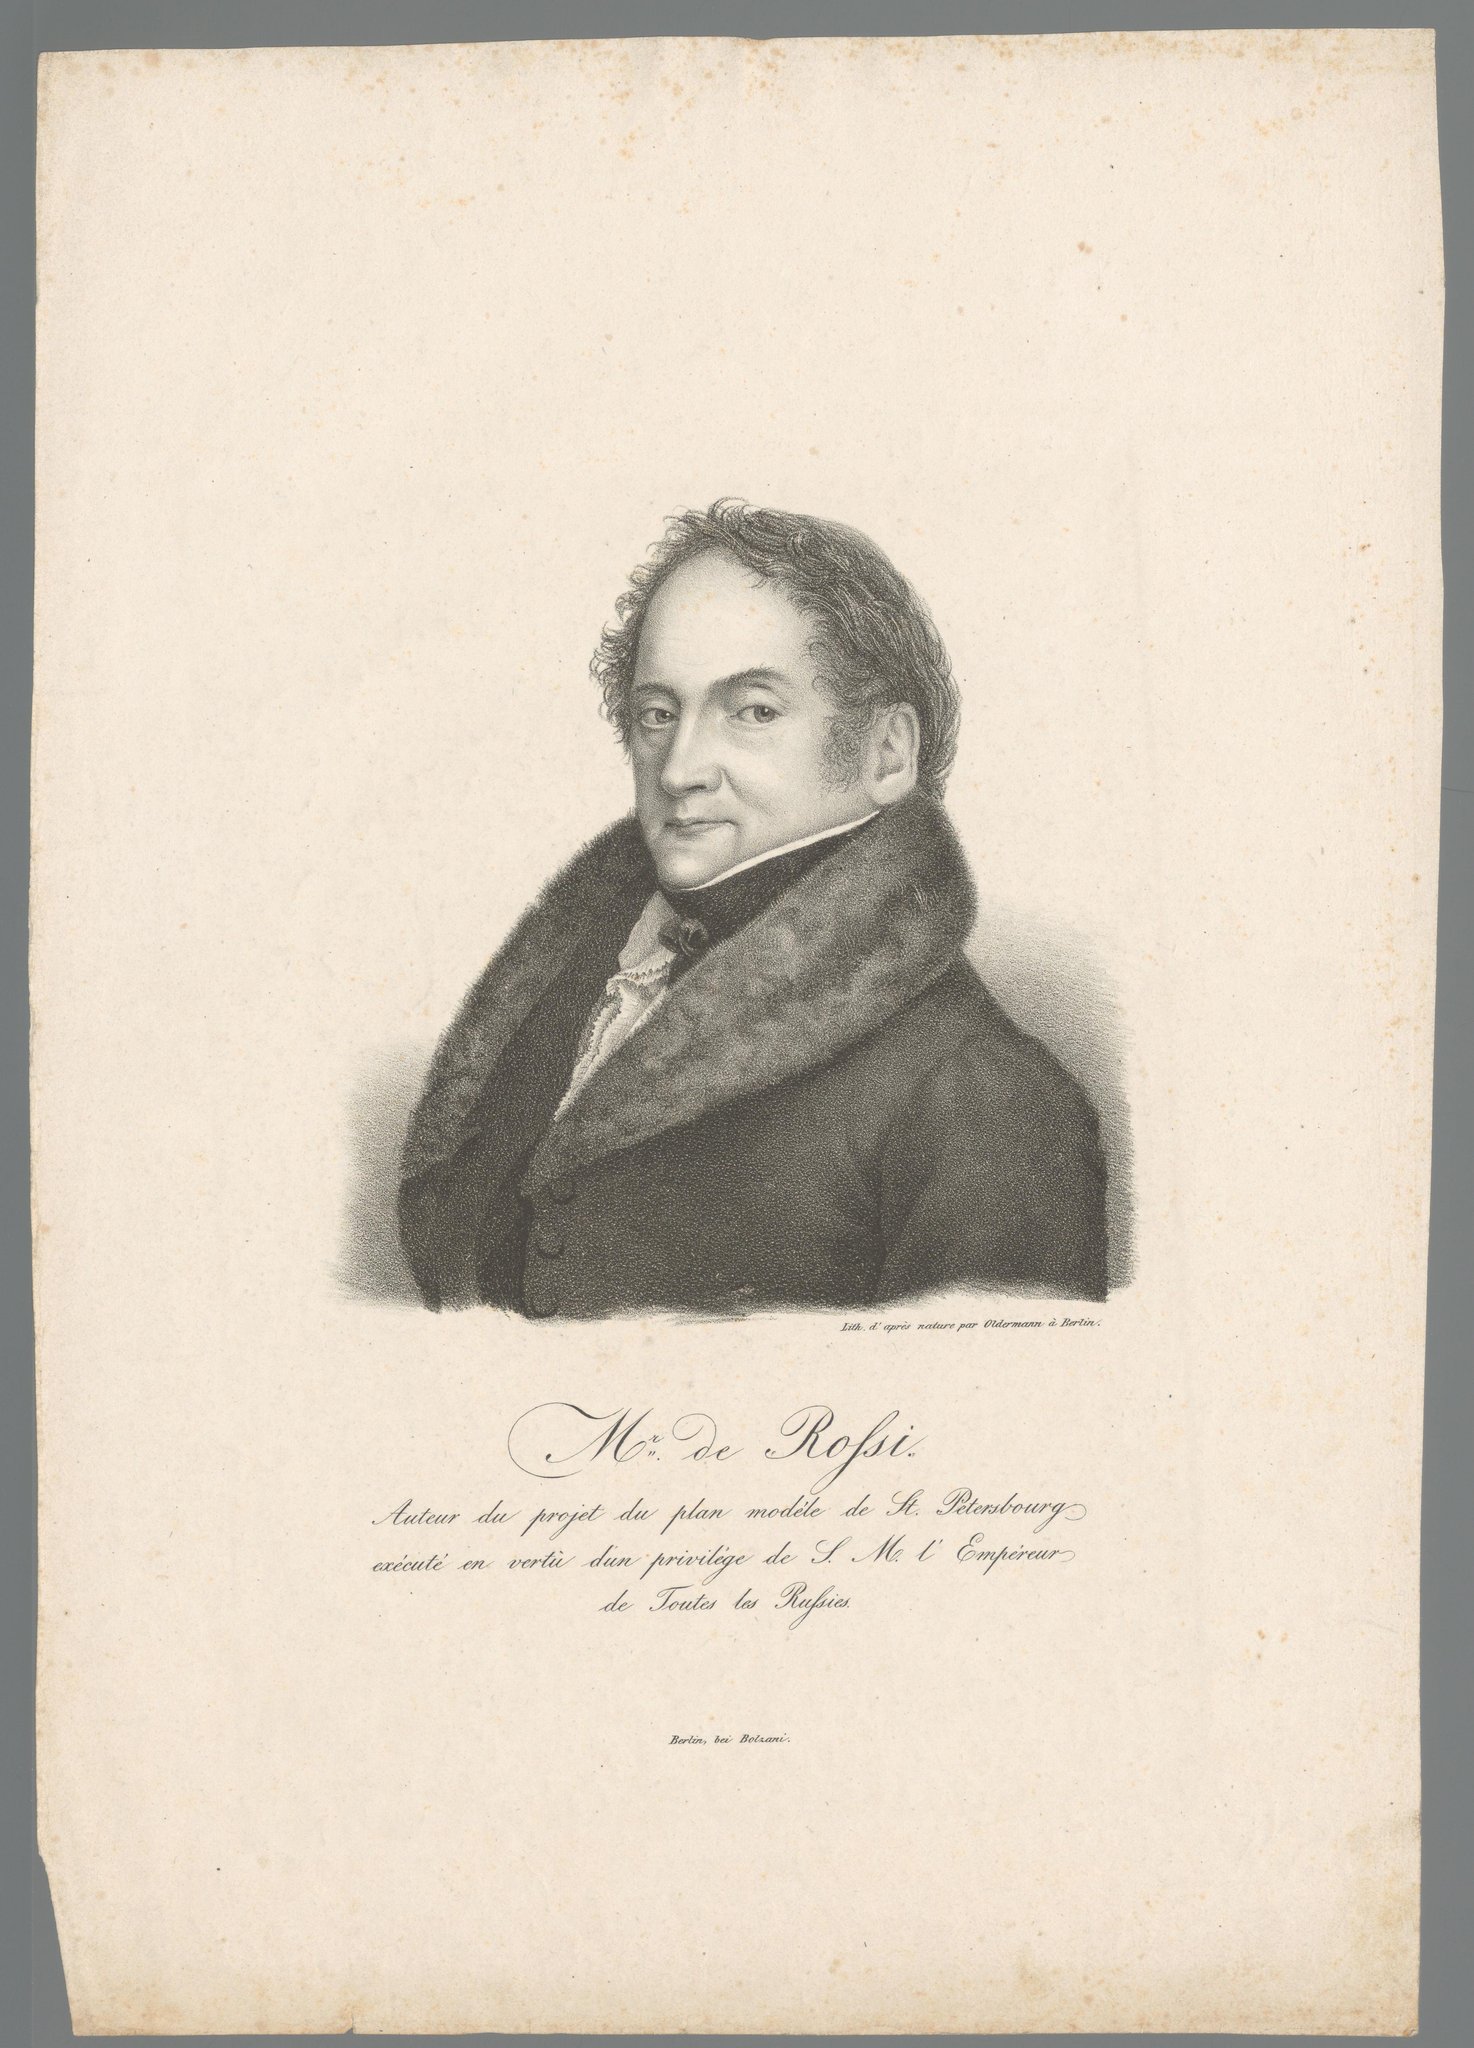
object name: print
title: Mr. de Rossi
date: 1820-1850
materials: paper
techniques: lithograph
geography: berlin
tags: adult man, historical persons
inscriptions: collector's mark: Lugt 2228